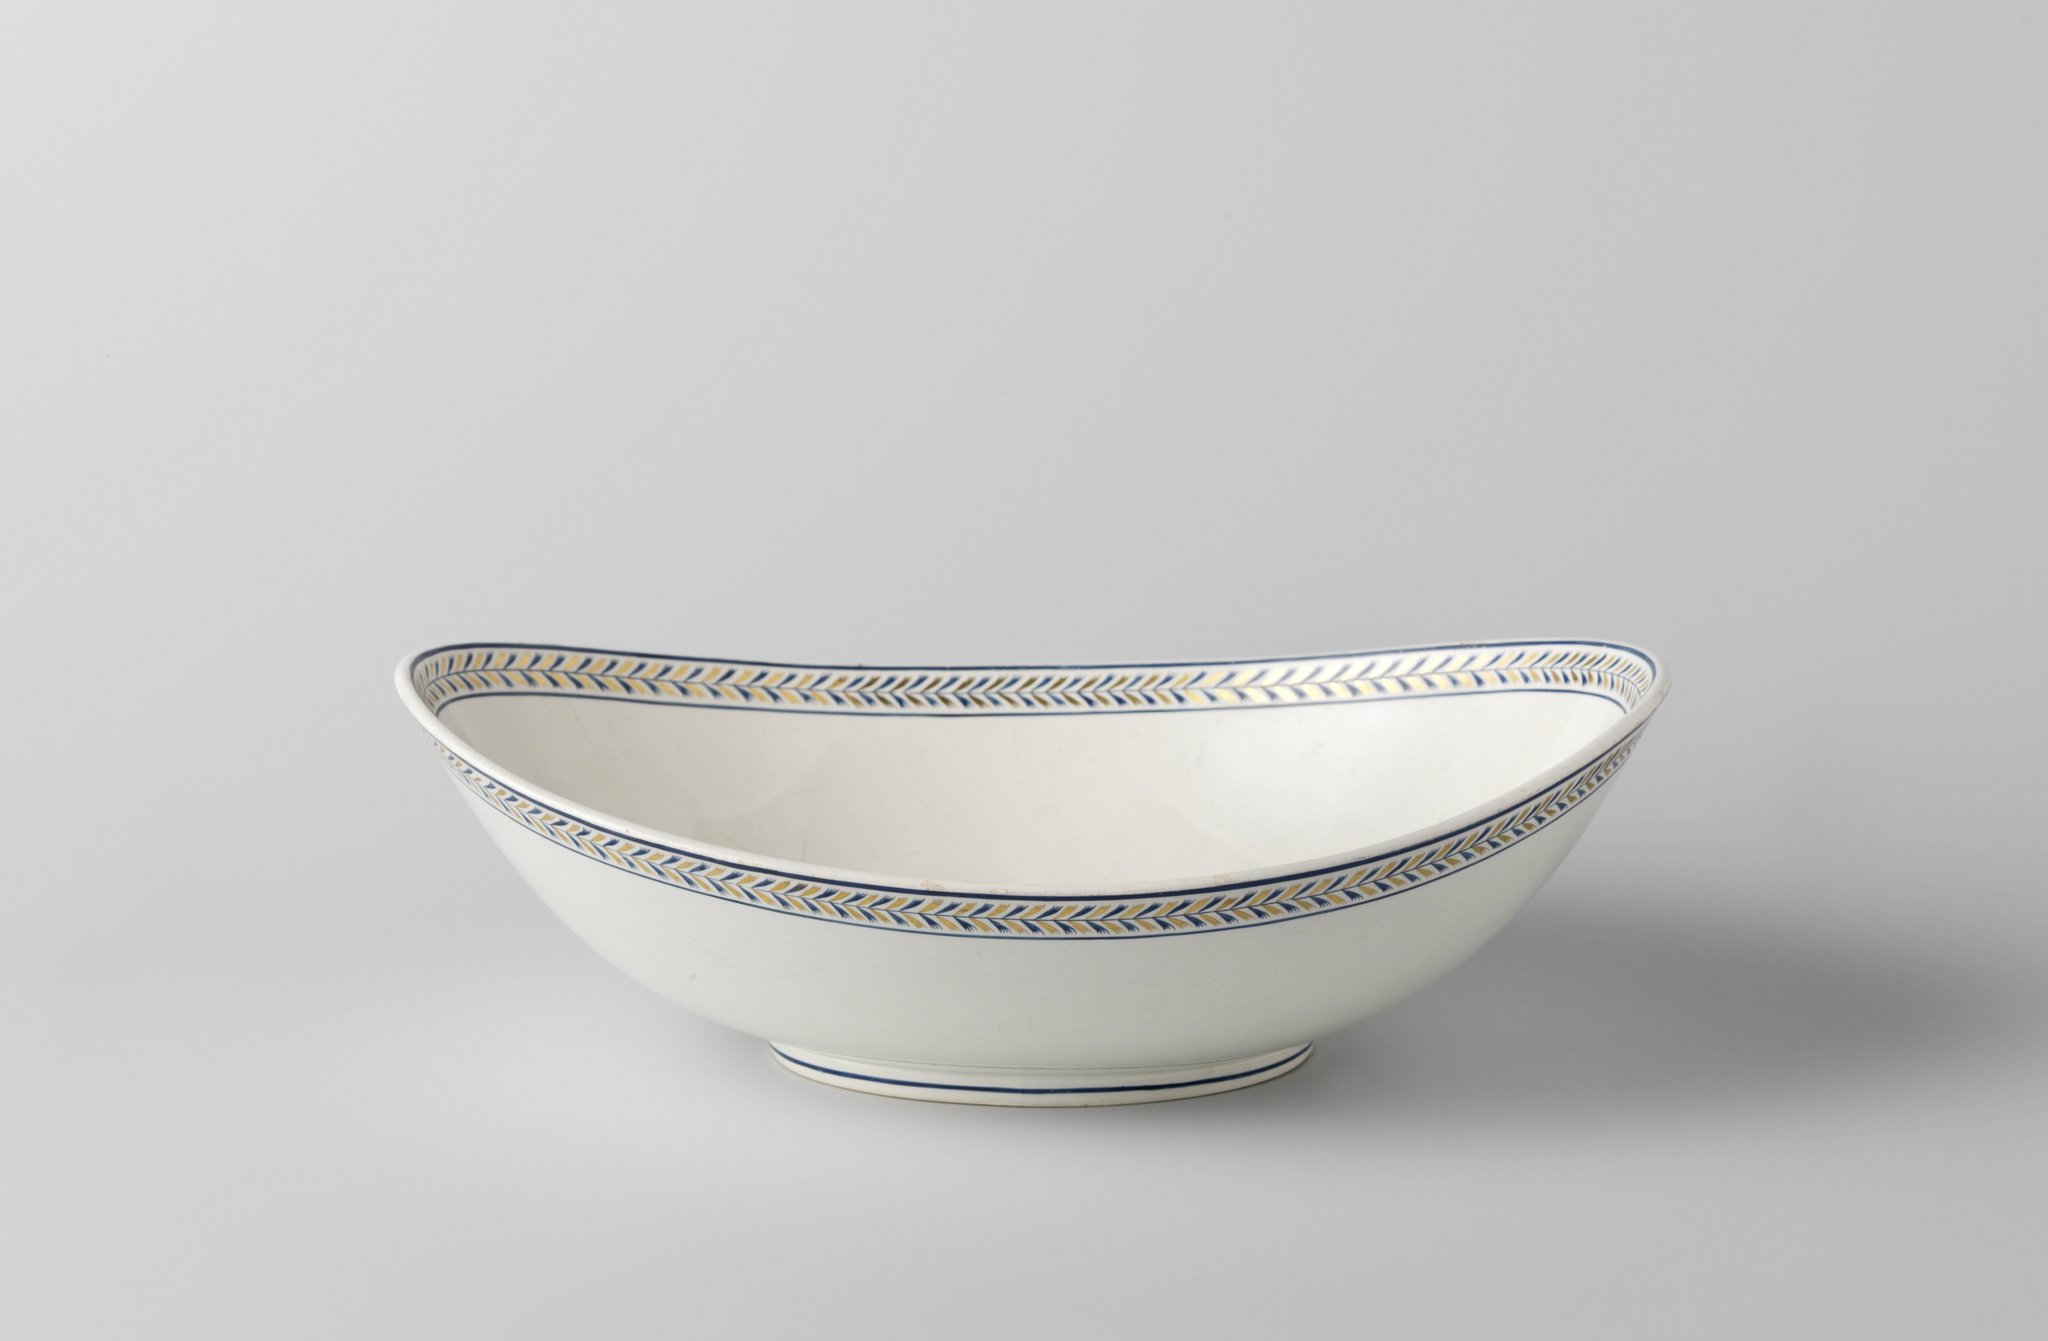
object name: dish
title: Broodschaal van hardgebakken aardewerk, Wedgwood cream ware.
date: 1800-1815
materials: earthenware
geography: england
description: Ovale broodschaal van hardgebakken aardewerk. De rand is versierd met ornamentbanden, bestaande uit een doorlopende blauwe tak met afwisselend blauw en gouden bladeren tussen blauwe biezen. De schaal is gemerkt. De schaal hoort bij een terrine (BK-1960-30-A) en een schotel (BK-1960-30-C).